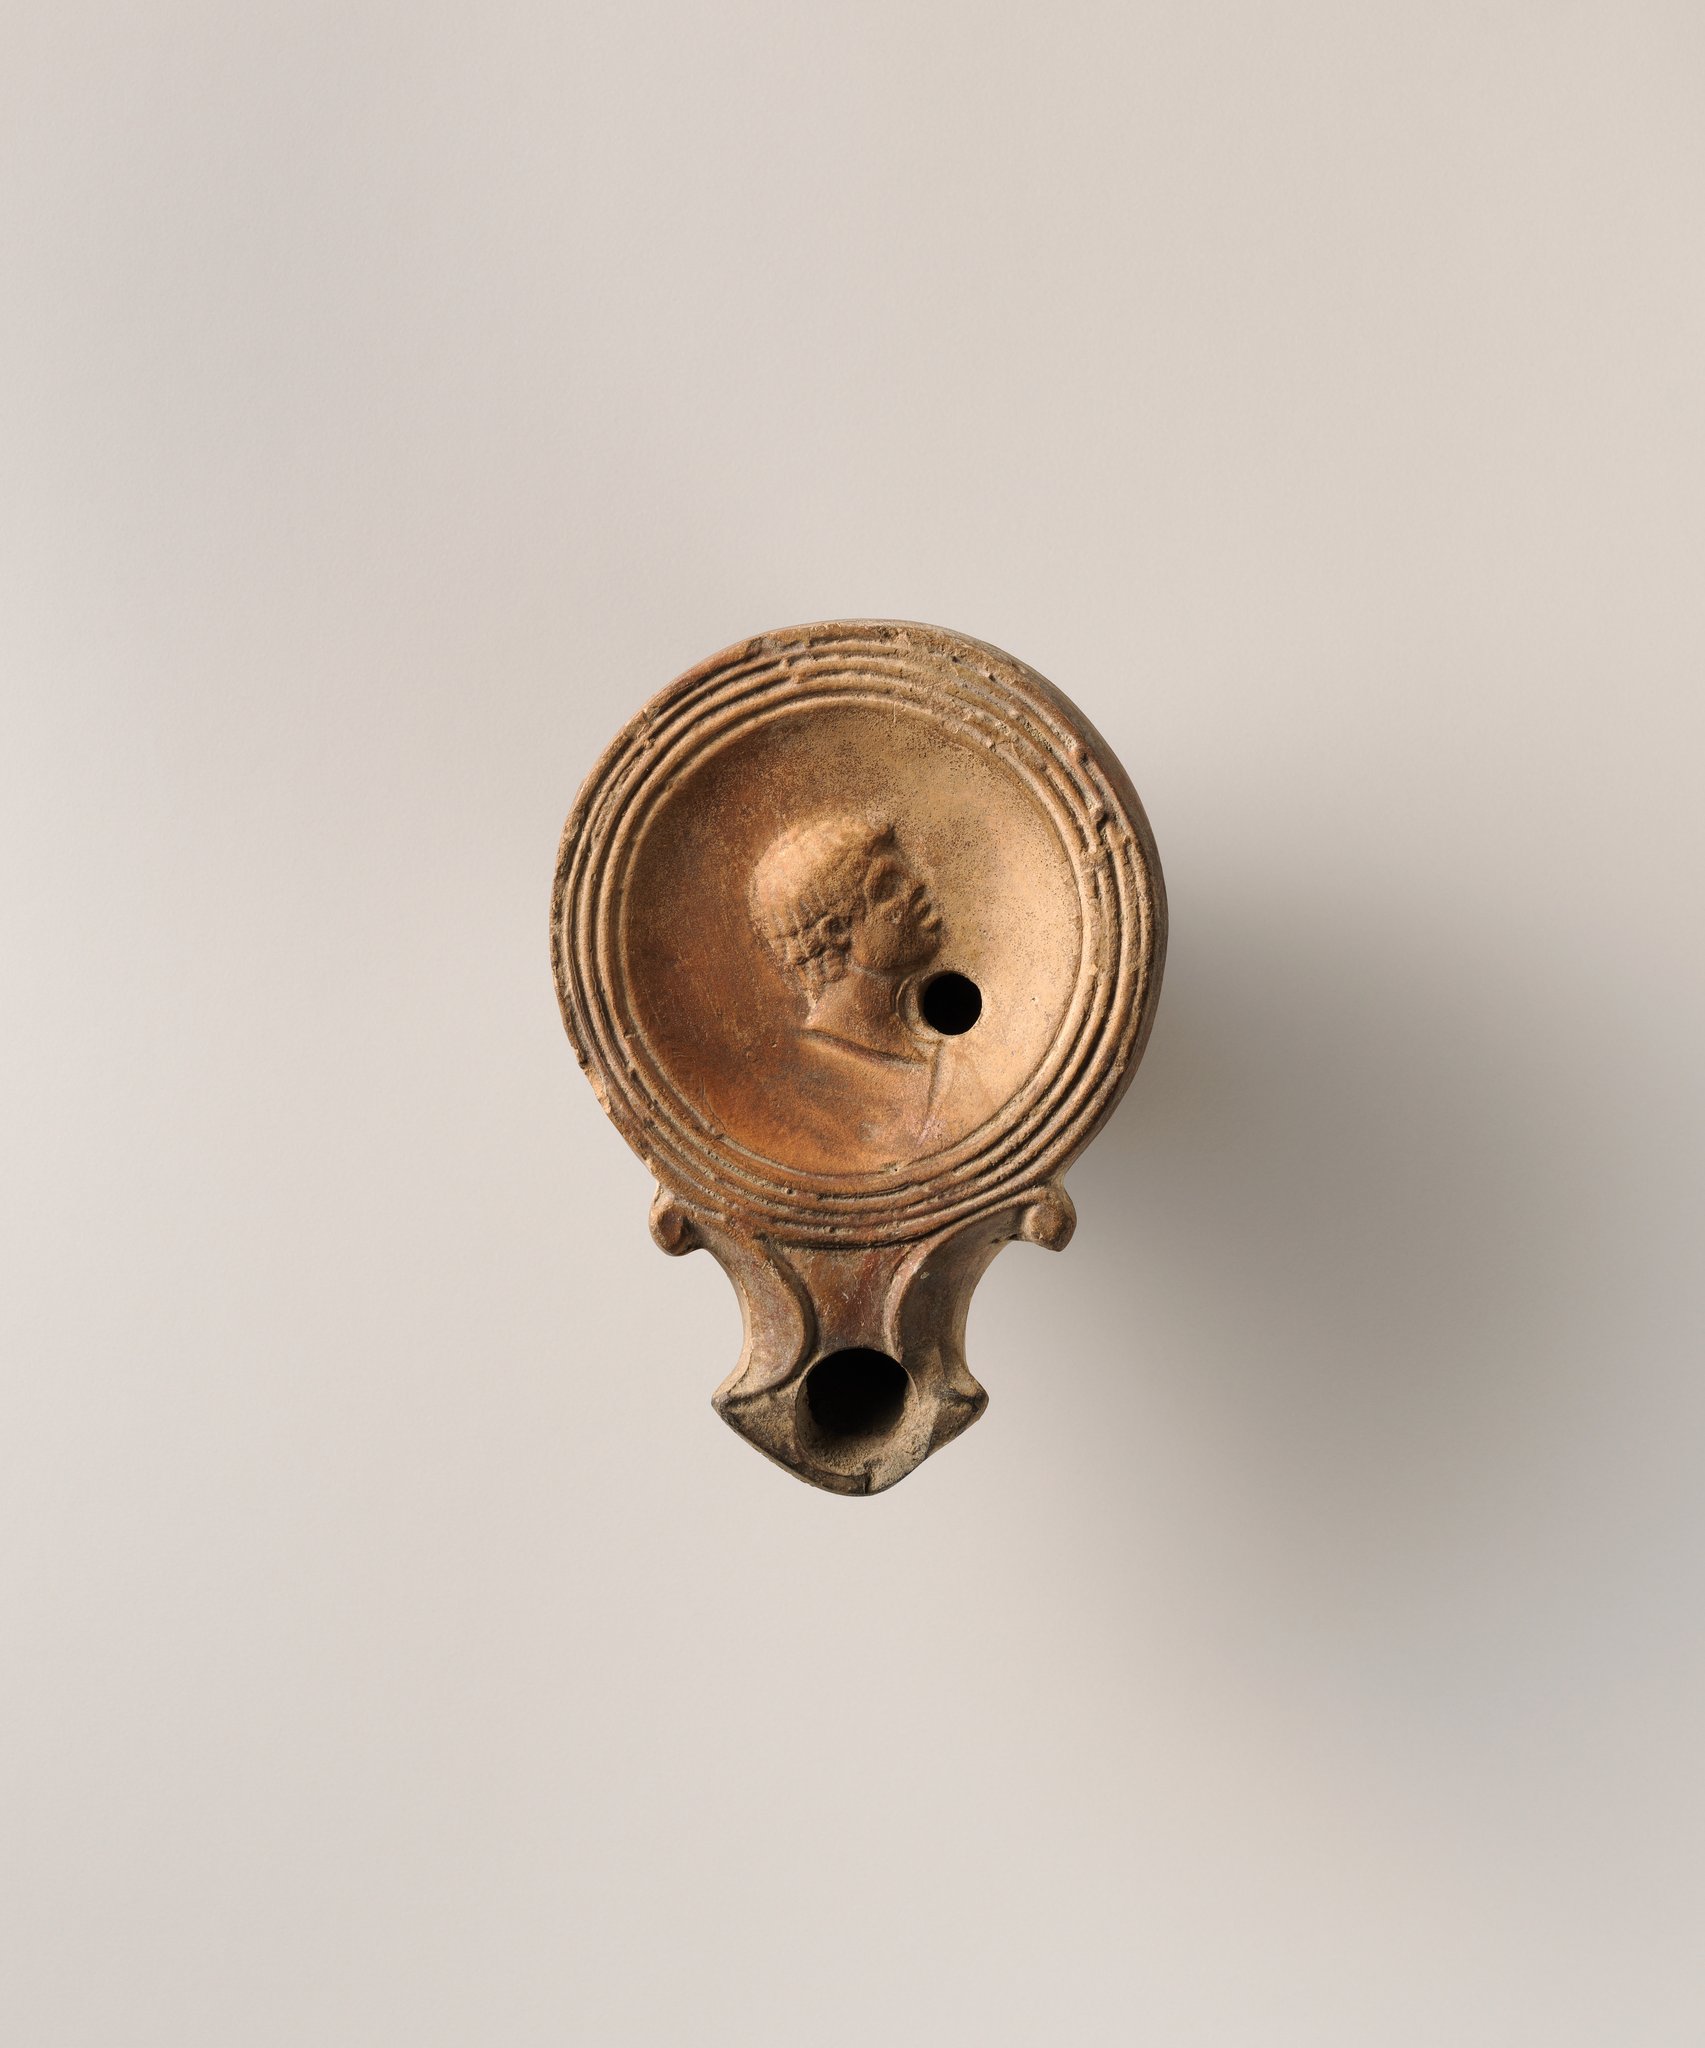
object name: lamp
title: Terracotta oil lamp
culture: roman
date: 1-33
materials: terracotta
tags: men